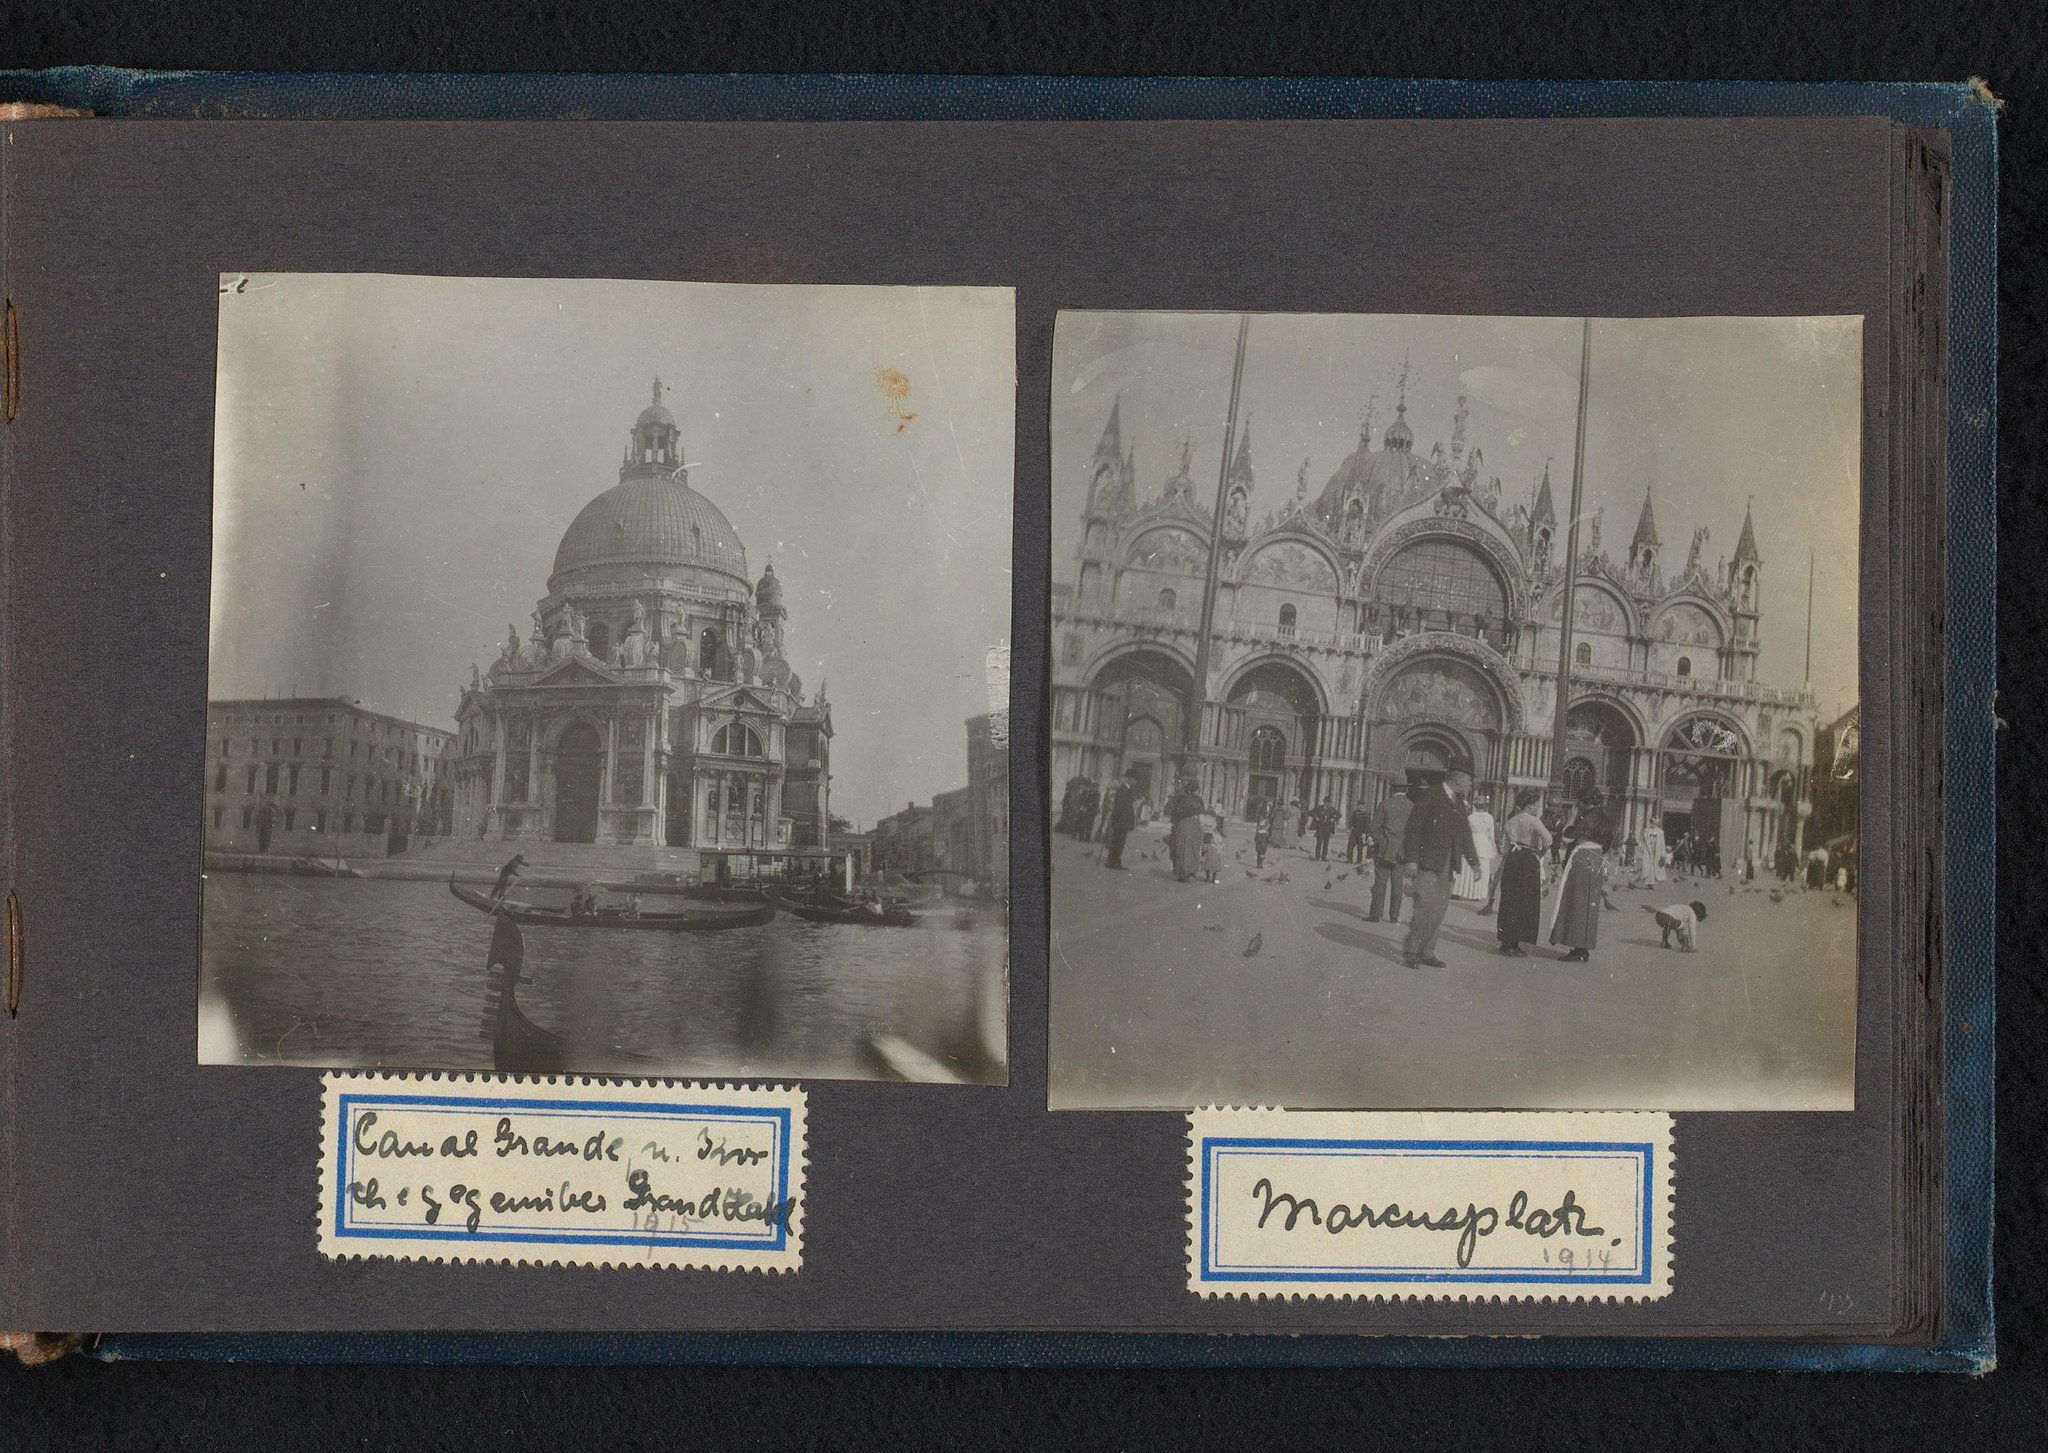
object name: album leaf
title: De familie in Venetië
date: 1914-1915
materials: paper, photographic support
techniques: gelatin silver print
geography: venice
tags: else wachenheimer-moos, willy moos, the family travelling, on holiday, tourism, venice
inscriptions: inscription: ‘Canal Grande u. Kirche gegenuber Grand Hotel 1915 / Marcusplatz. 1914’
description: Albumblad met twee foto's van Else Moos met haar ouders en enkele andere familieleden in Venetië. Onderdeel van het fotoalbum van Else Wachenheimer-Moos en haar broers Arthur en Willy Moos en anderen in de periode 1913-1918.